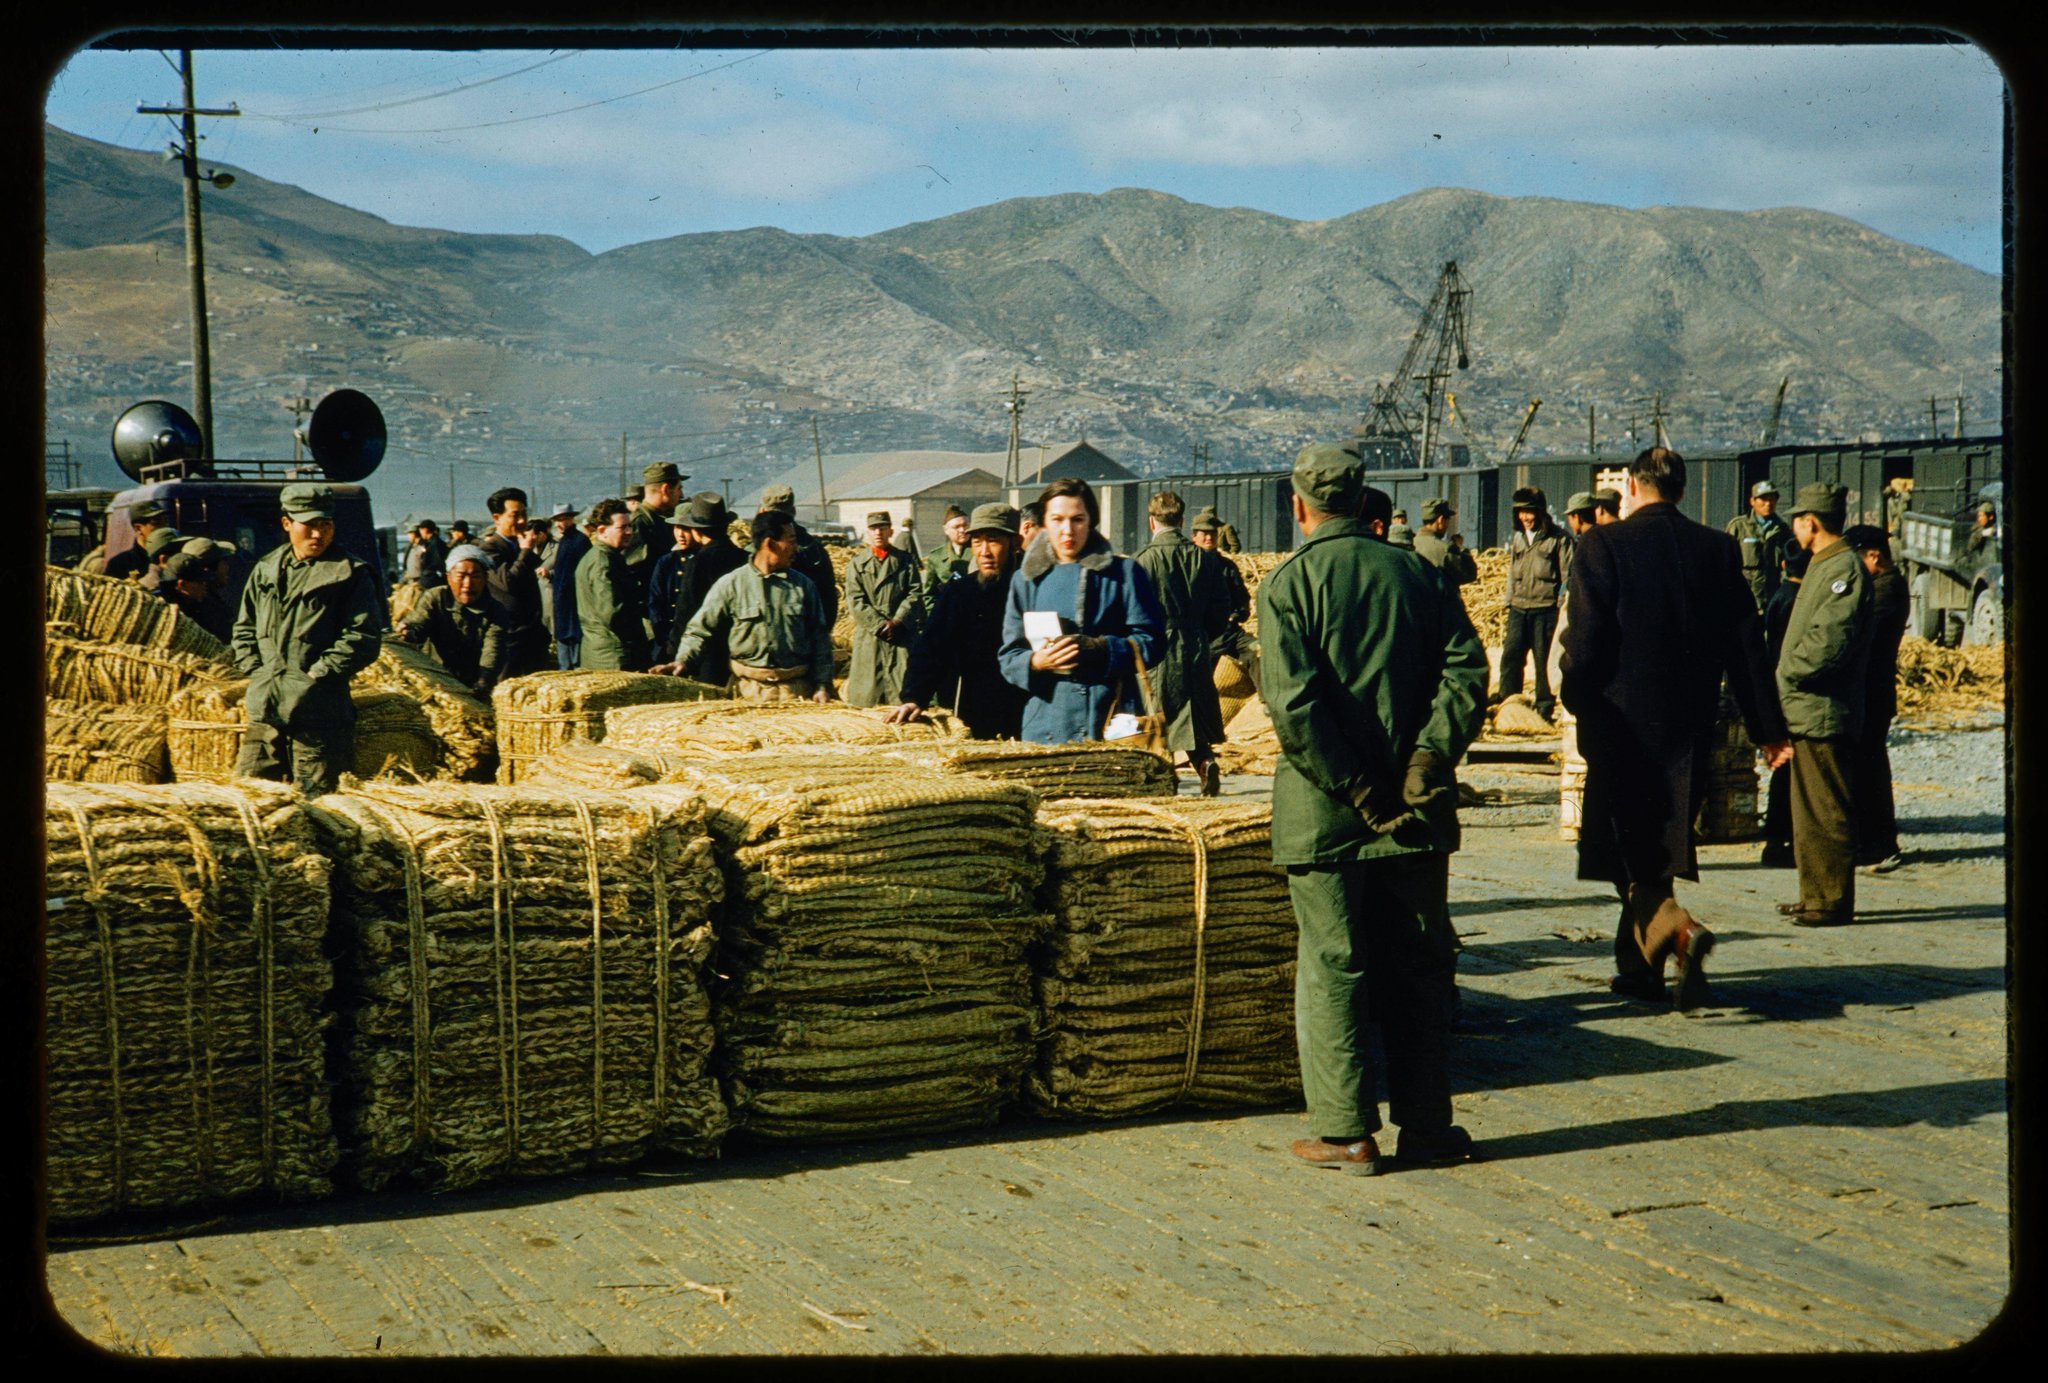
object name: color slide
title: Aankomst van het graanschip van UNKRA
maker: david ketel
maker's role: diplomaat, sinoloog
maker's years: 1913-2008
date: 1901-1953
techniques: slide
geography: korea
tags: united nations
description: United Nations Korean Reconstruction Agency